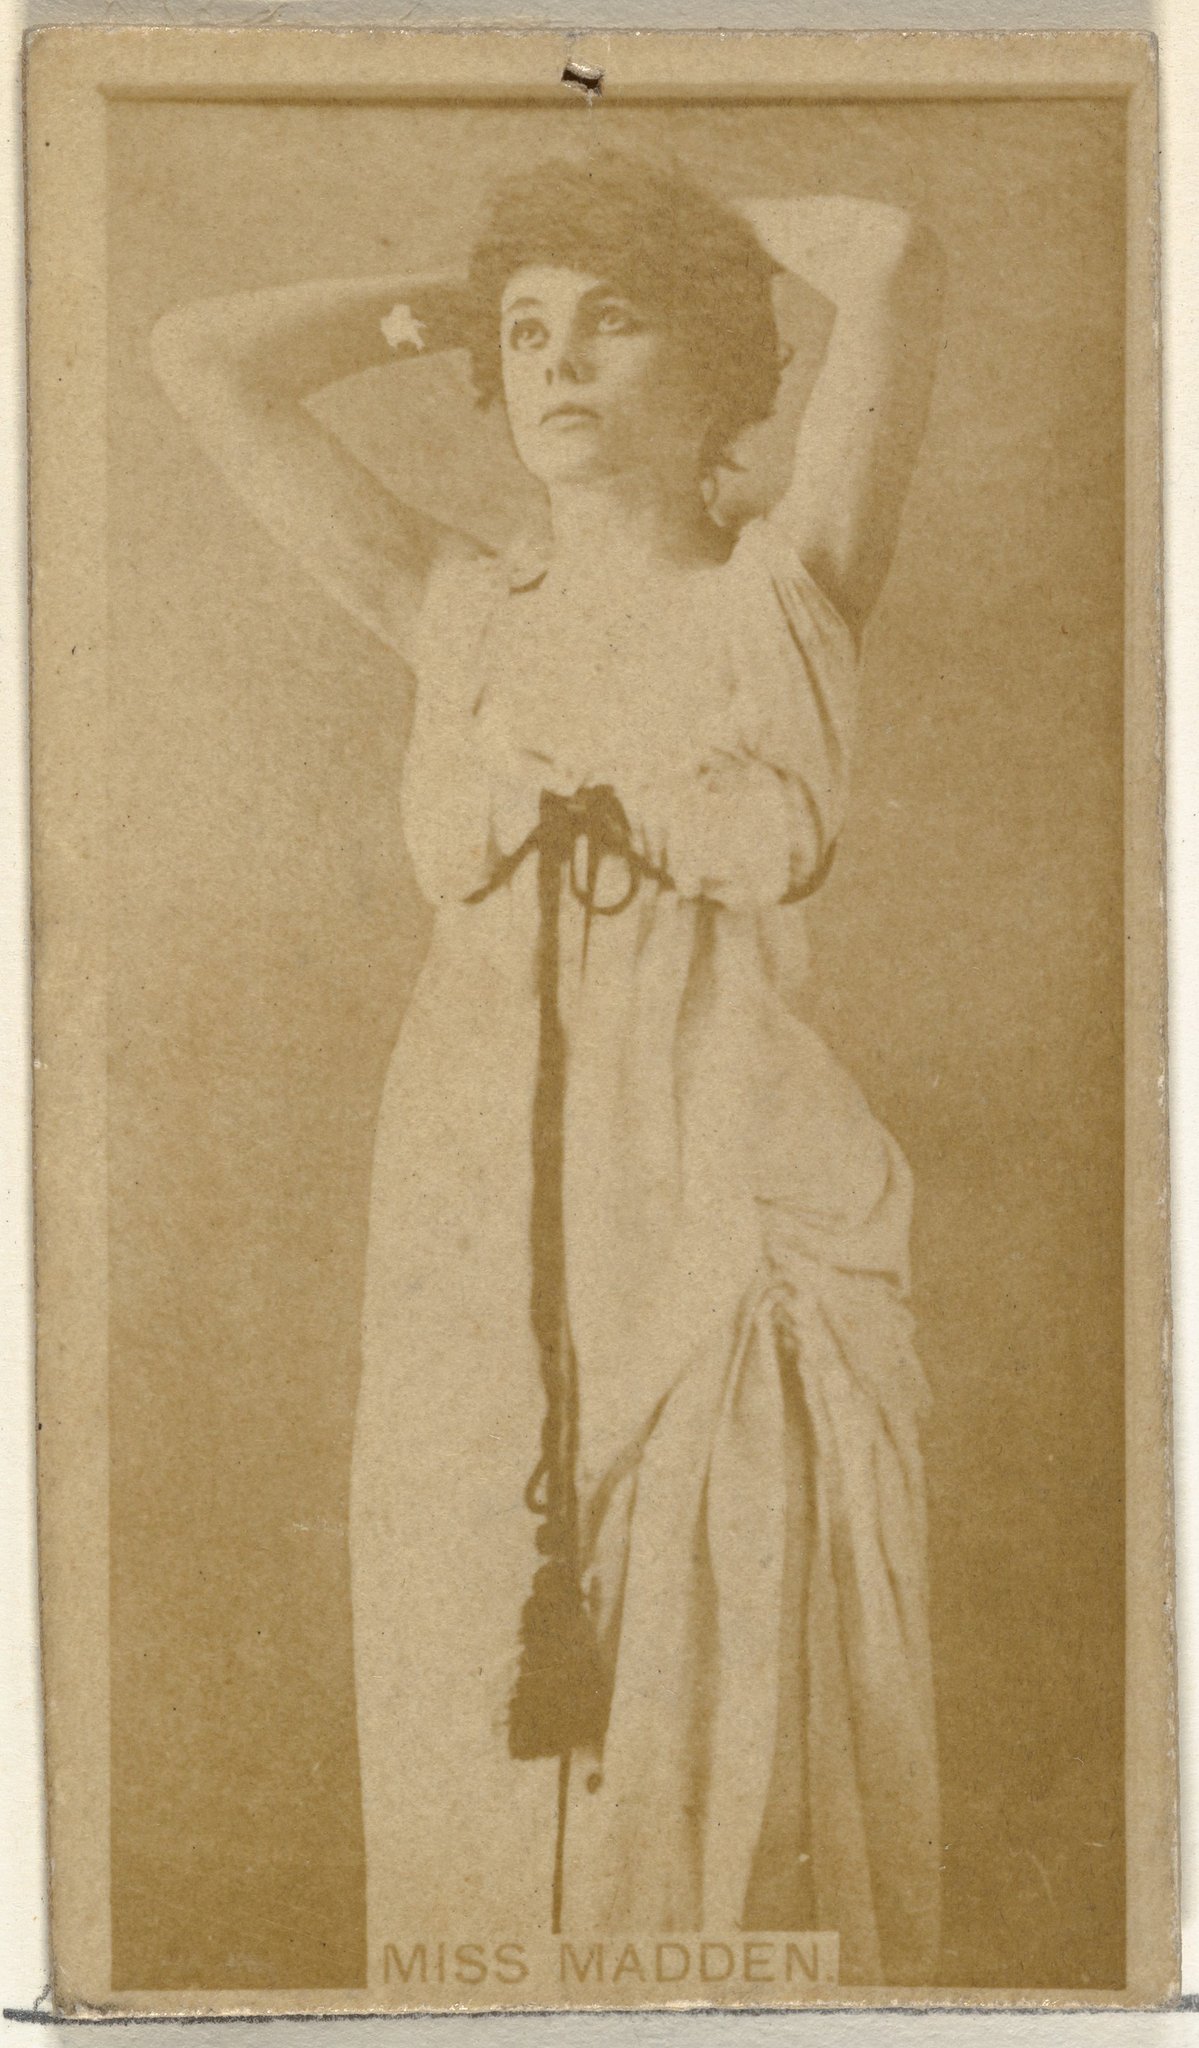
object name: photograph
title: Miss Madden, from the Actors and Actresses series (N145-8) issued by Duke Sons & Co. to promote Duke Cigarettes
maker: w. duke, sons & co.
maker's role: publisher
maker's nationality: american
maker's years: 1870-1920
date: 1891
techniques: albumen silver print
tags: portraits,women,actresses